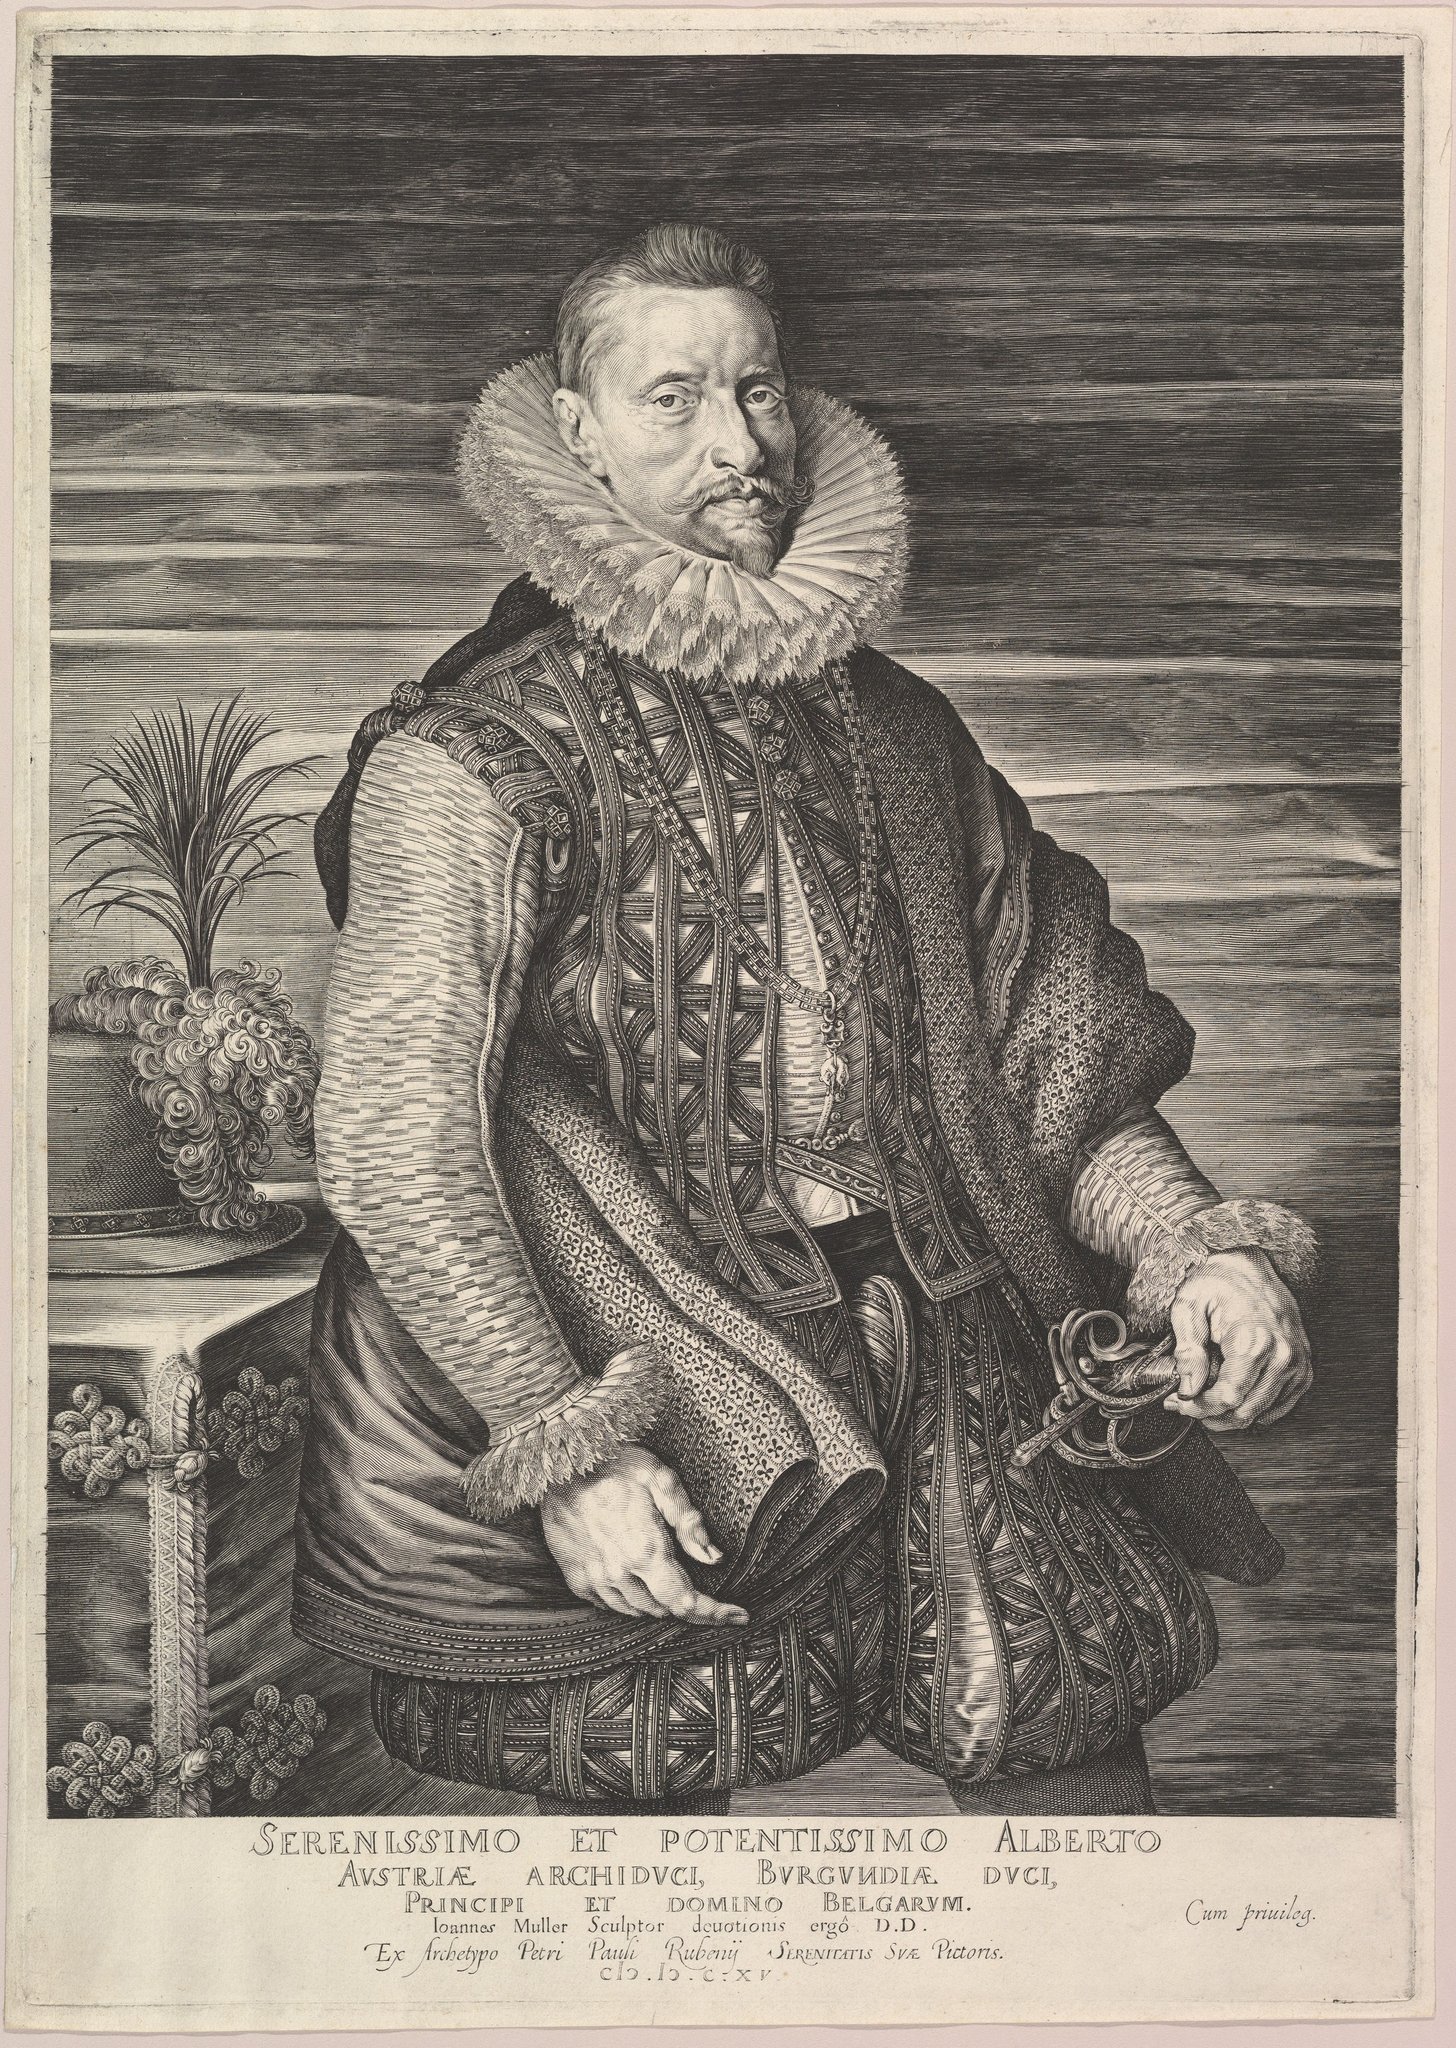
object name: print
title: Portrait of Albert, Archduke of Austria, Sovereign of the Southern Netherlands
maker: jan muller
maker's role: artist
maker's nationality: netherlandish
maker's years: 1571-1628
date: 1615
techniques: engraving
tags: men,portraits